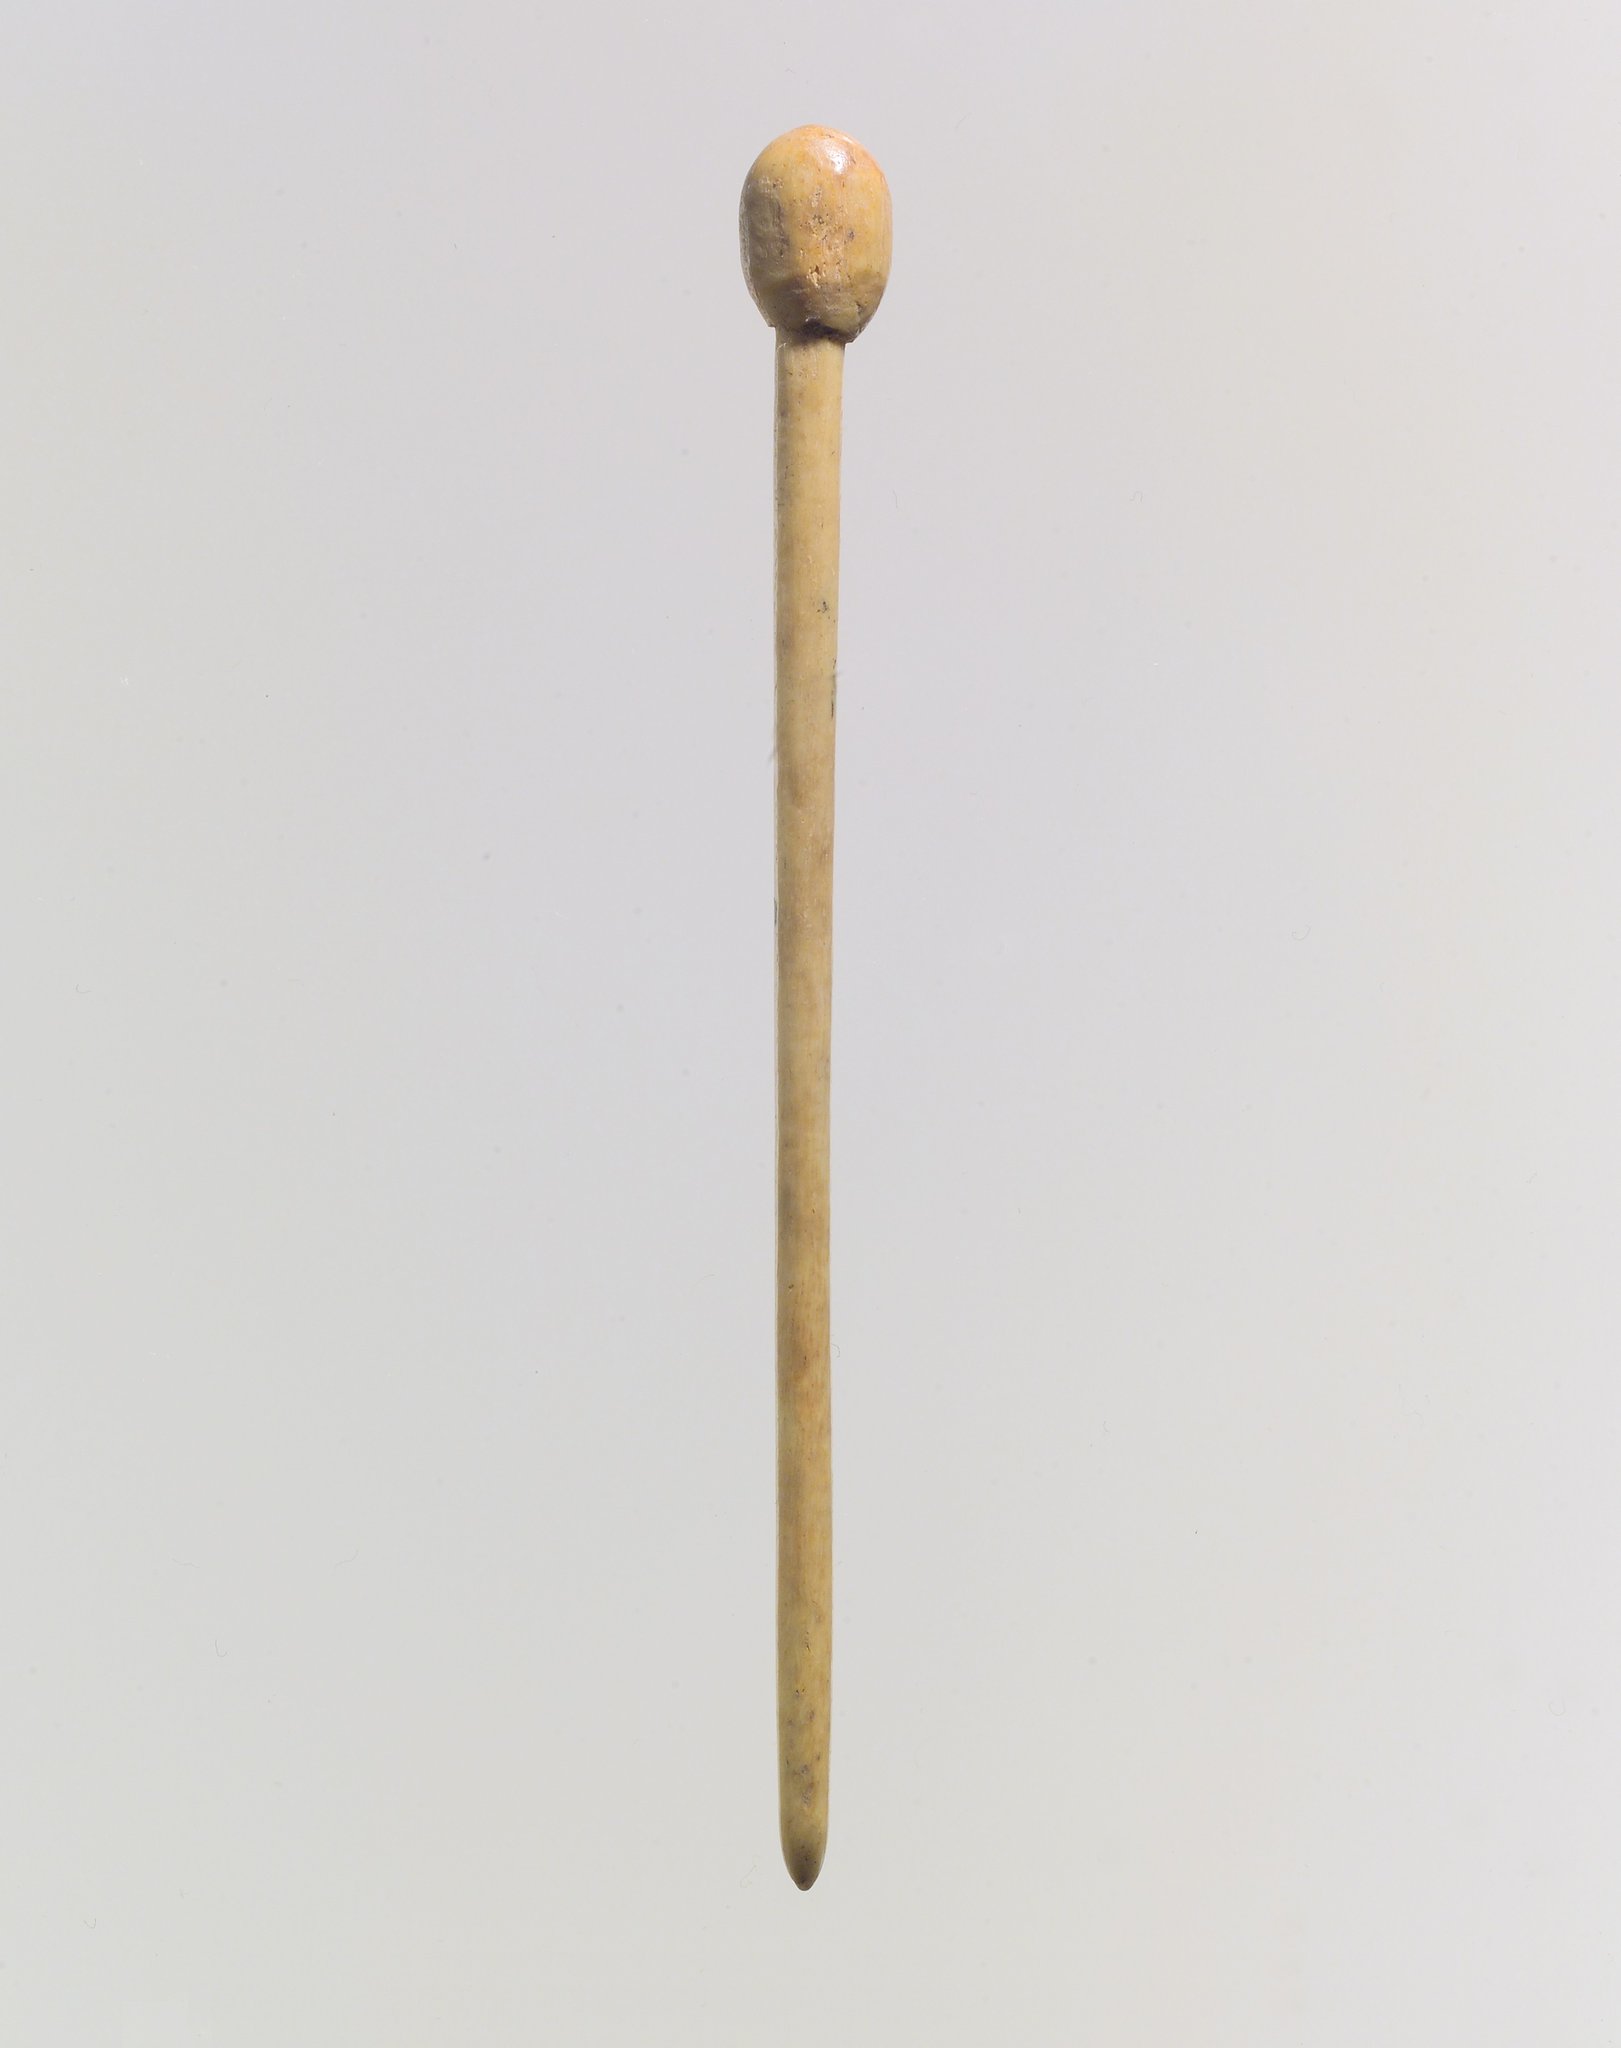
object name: pin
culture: sasanian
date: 201-700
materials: ivory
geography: mesopotamia